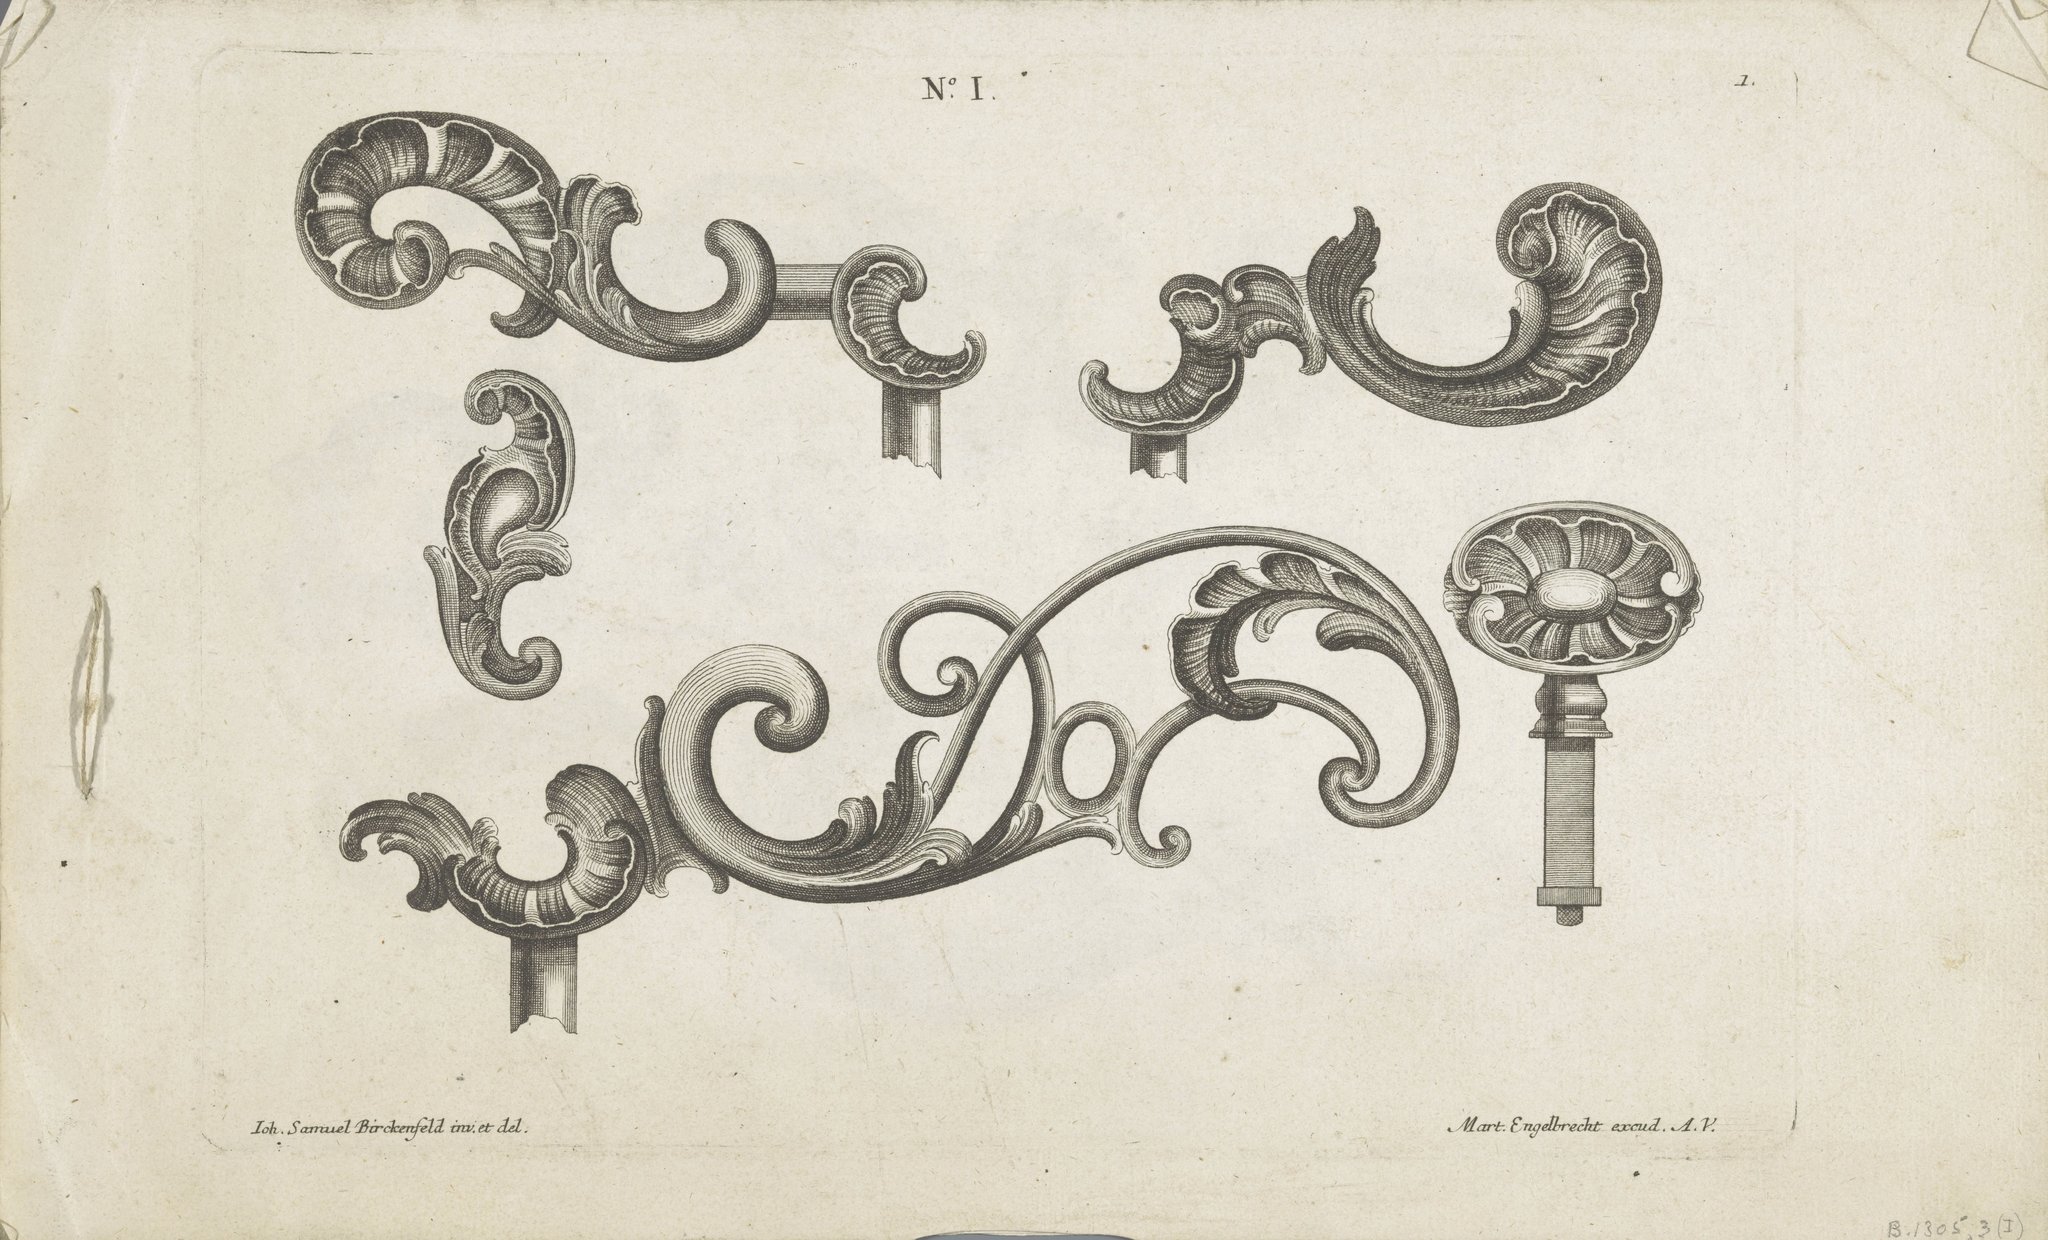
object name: print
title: Ontwerpen voor sloten en sleutels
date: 1694-1756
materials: paper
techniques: etching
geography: augsburg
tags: lock ~ door, rocaille ornament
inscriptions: collector's mark: Lugt 2228